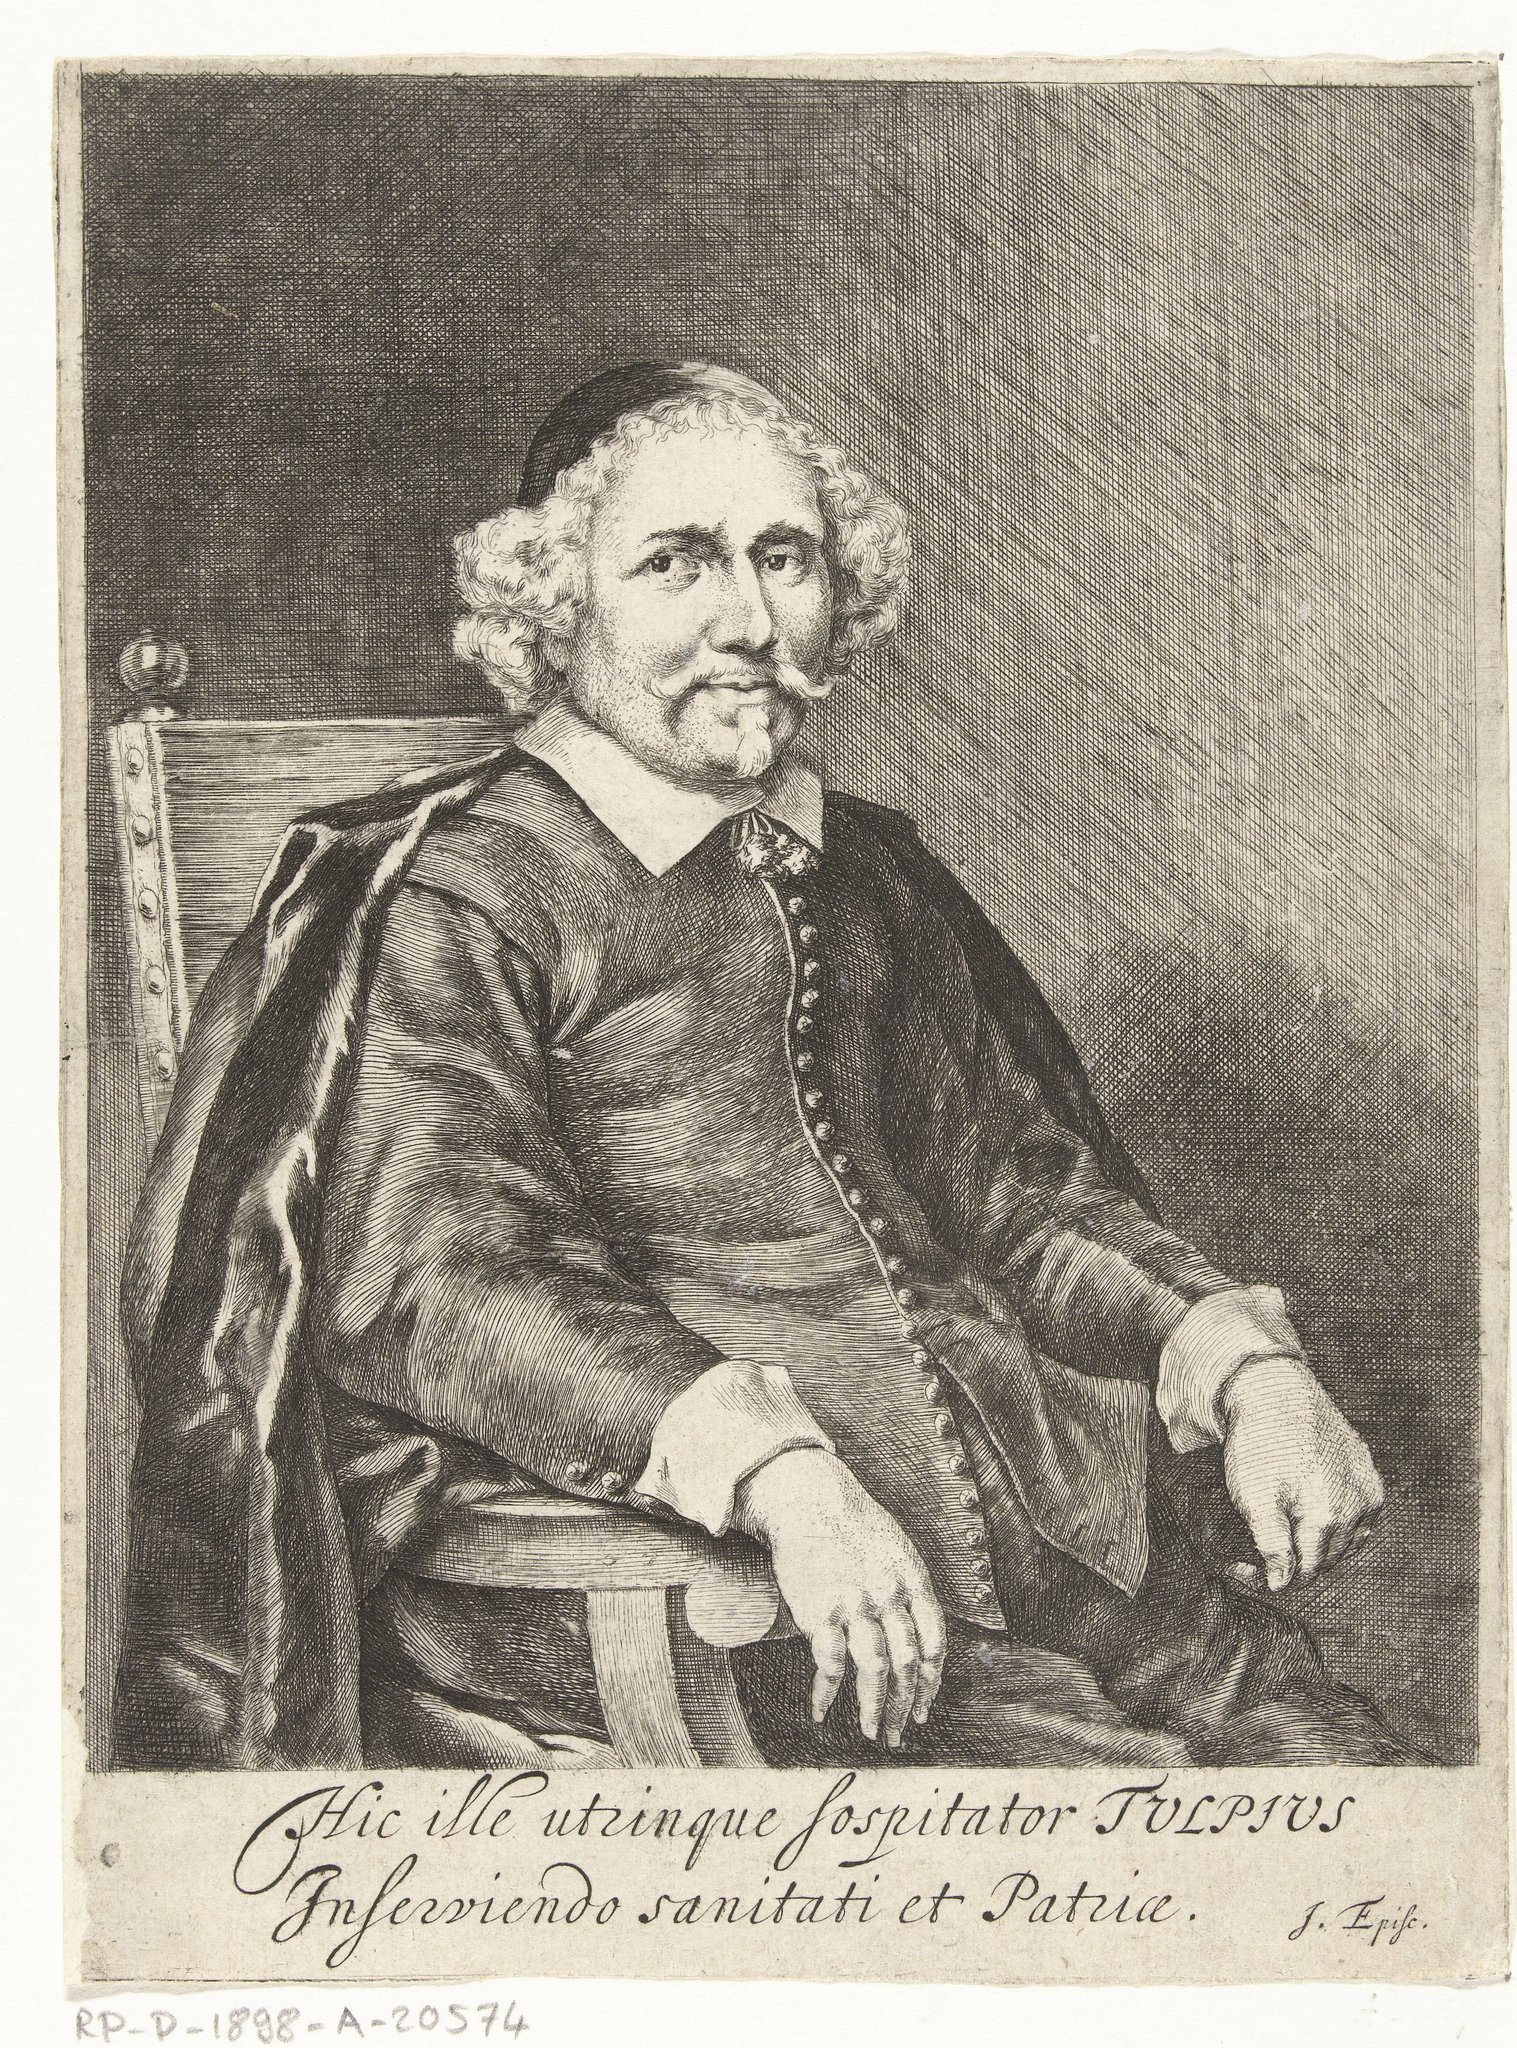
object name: print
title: Portret van Nicolaas Tulp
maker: jan de bisschop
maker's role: draughtsman, print maker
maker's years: 1628-1671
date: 1638-1671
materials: paper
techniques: etching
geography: amsterdam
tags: amsterdam, the hague, mayor, physician, doctor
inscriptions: collector's mark: Lugt 964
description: Portret van dr. Nicolaas (Claes Pieterszoon) Tulp, een van de beroemdste artsen uit de 17e eeuw en burgemeester van Amsterdam. Kniestuk, zittend op een stoel, naar rechts gekeerd.